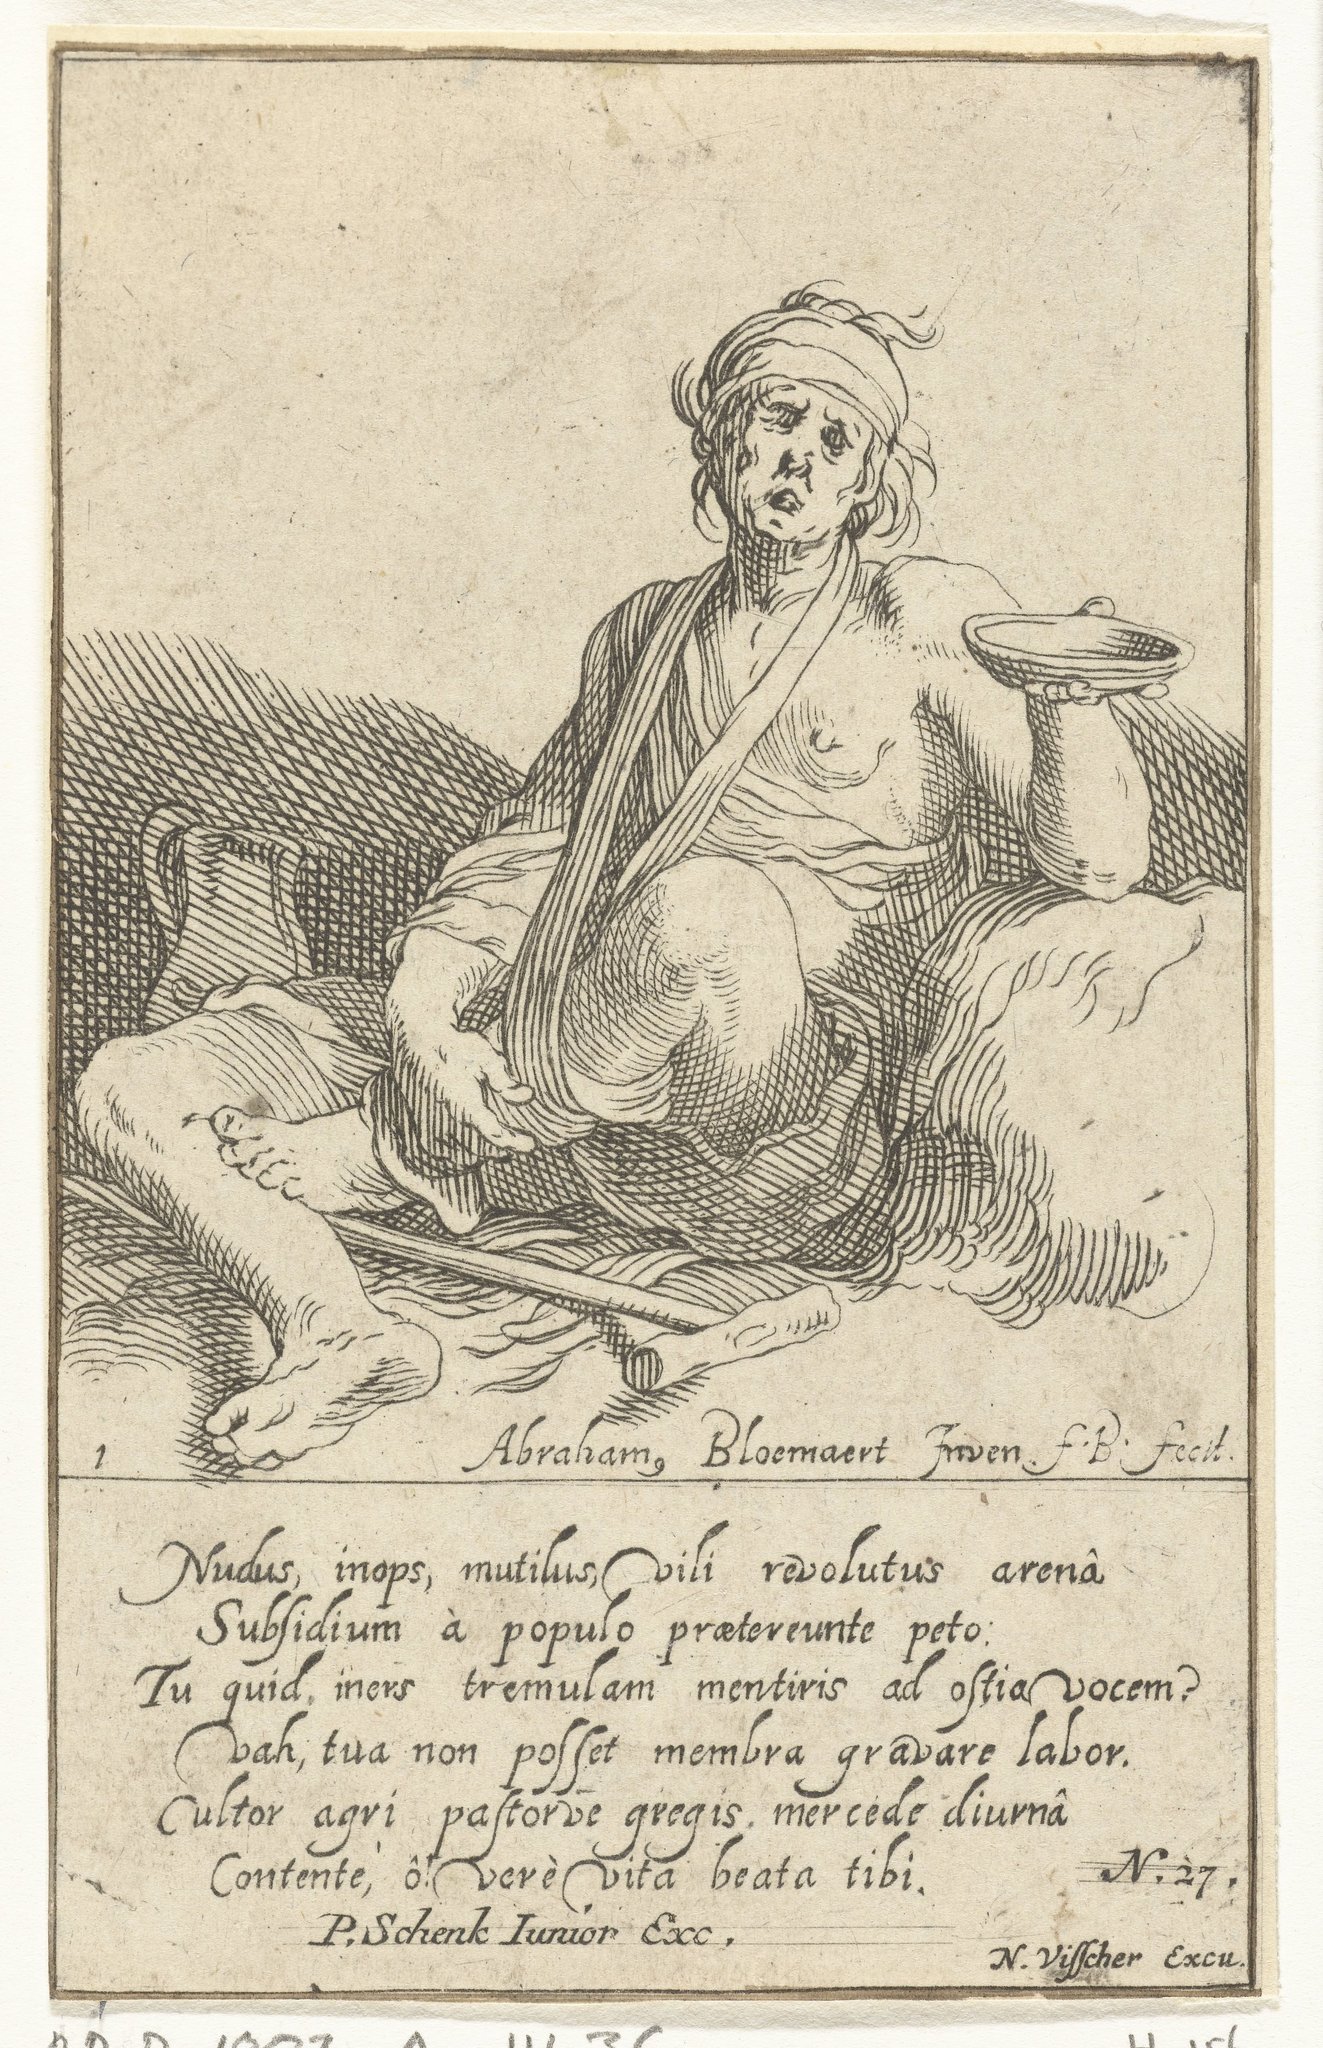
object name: titelprent, frontispice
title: Zittende bedelende man met zijn been in een mitella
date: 1728-1761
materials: paper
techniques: engraving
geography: amsterdam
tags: disabilities, deformations, beggar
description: Een zittende bedelende man die een lege kom ophoudt. Naast hem liggen zijn krukken. Met Latijns onderschrift.